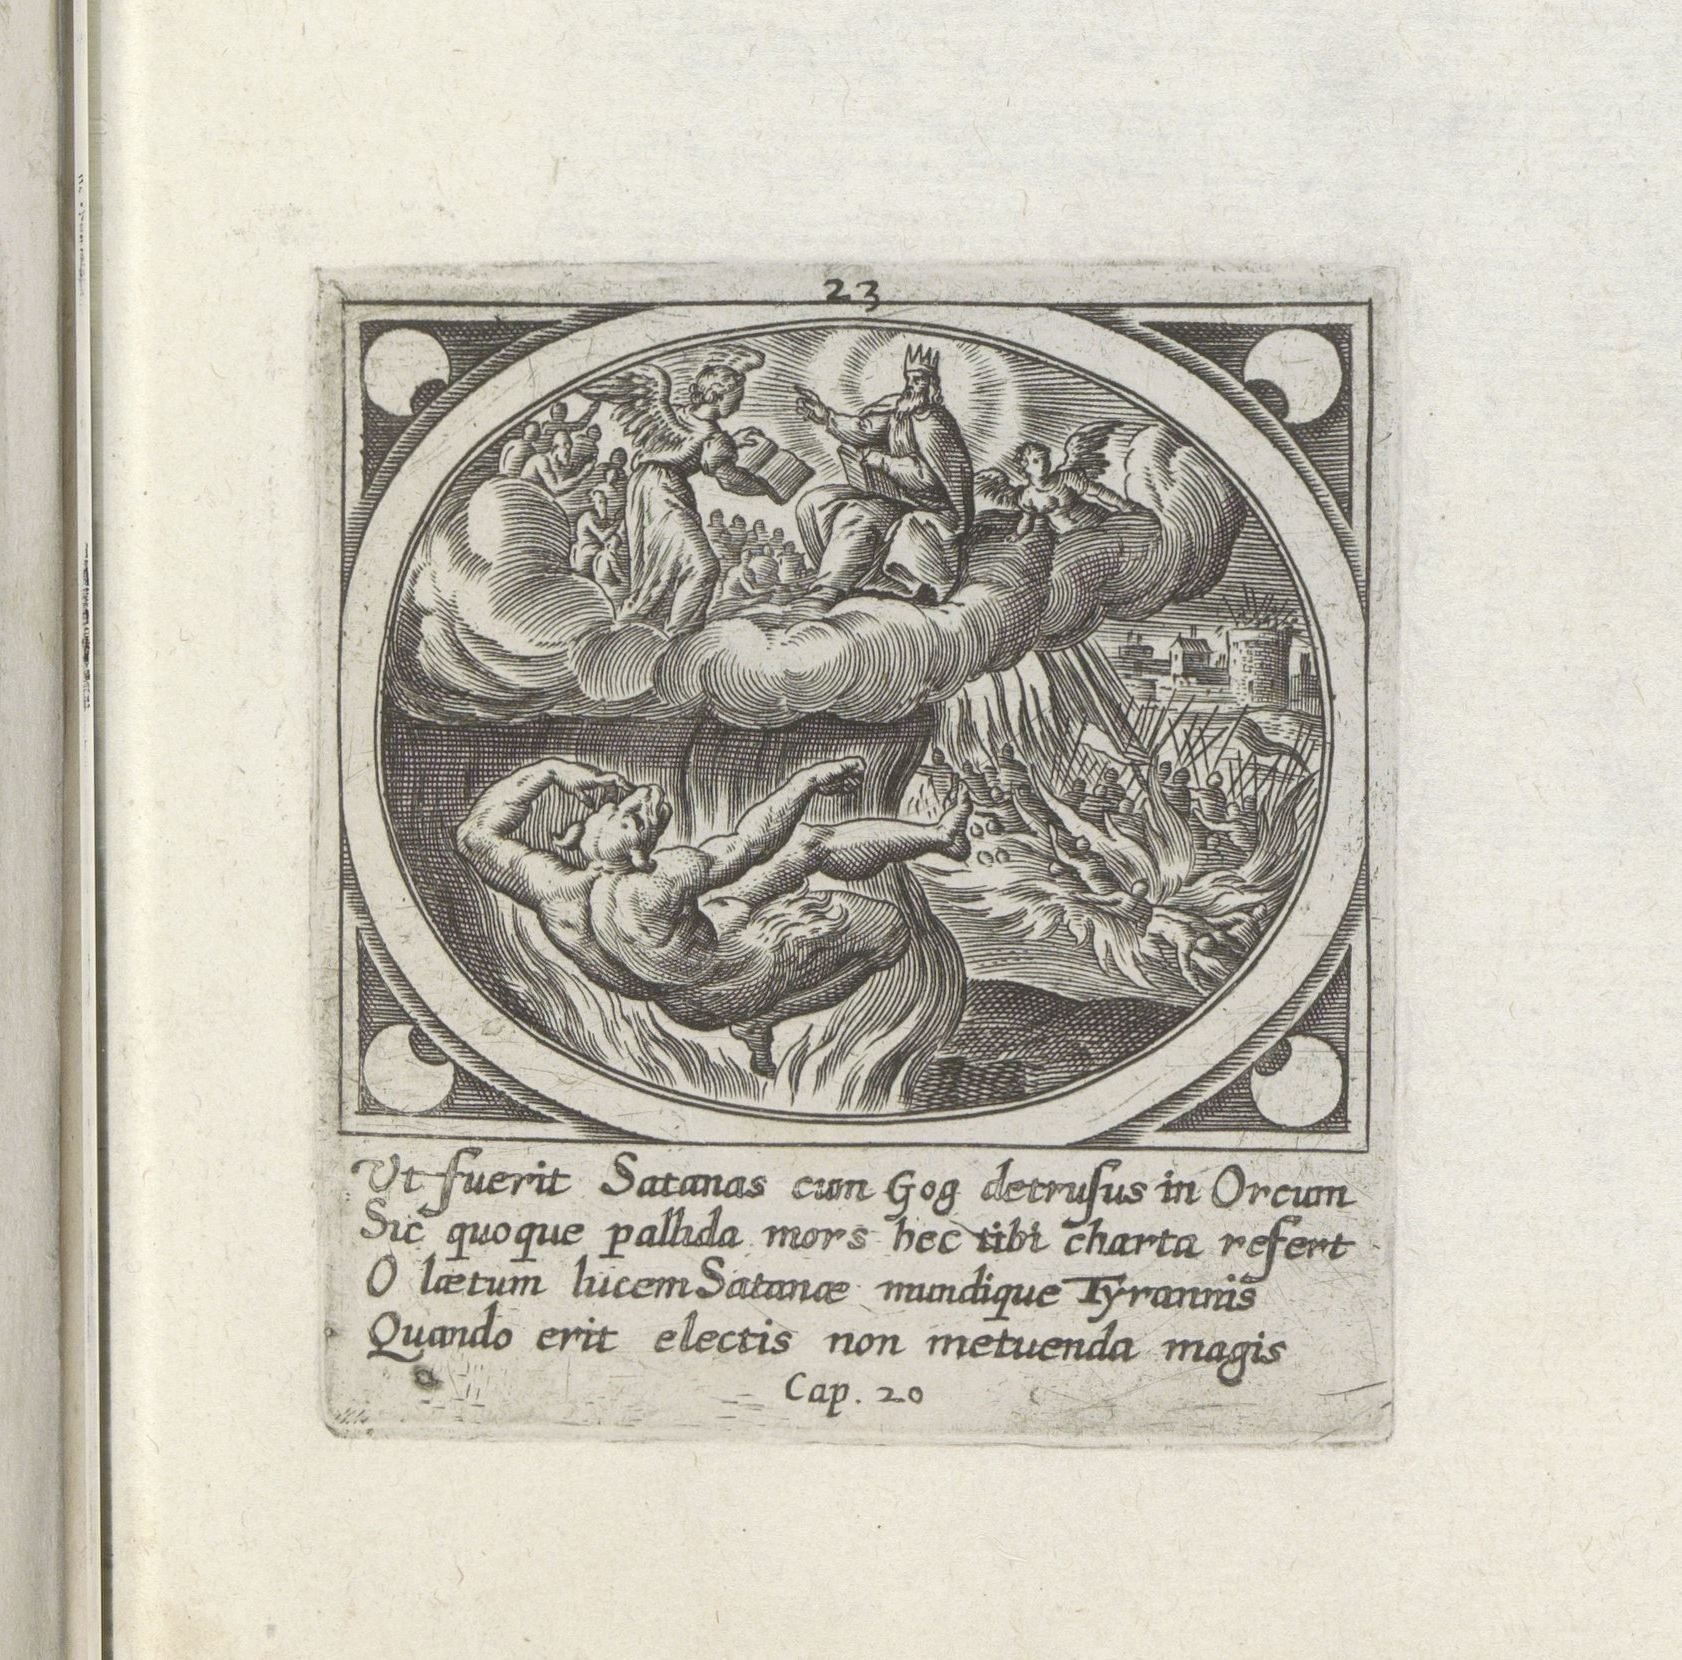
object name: album leaf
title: Openbaring van Johannes op Patmos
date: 1585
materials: paper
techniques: engraving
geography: antwerp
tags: death and hell are cast into the lake of fire, the judge on the great white throne, an angel with a key and a chain binds the dragon (satan) and casts him into the pit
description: Hemel met God de Vader, zittend op troon, omringd door de opgestane doden. Tegenover hem staat een engel met een open boek. Op de achtergrond wordt iedereen die niet in het boek van het leven blijkt te staan in de vuurpoel gegooid (de tweede dood). De duivel, na duizend jaar weer bevrijd, wordt in de poel van vuur en zwavel geworpen. Onder de voorstelling een verwijzing in het Latijn naar de Bijbeltekst in Op. 20. Deze prent maakt deel uit van een album.